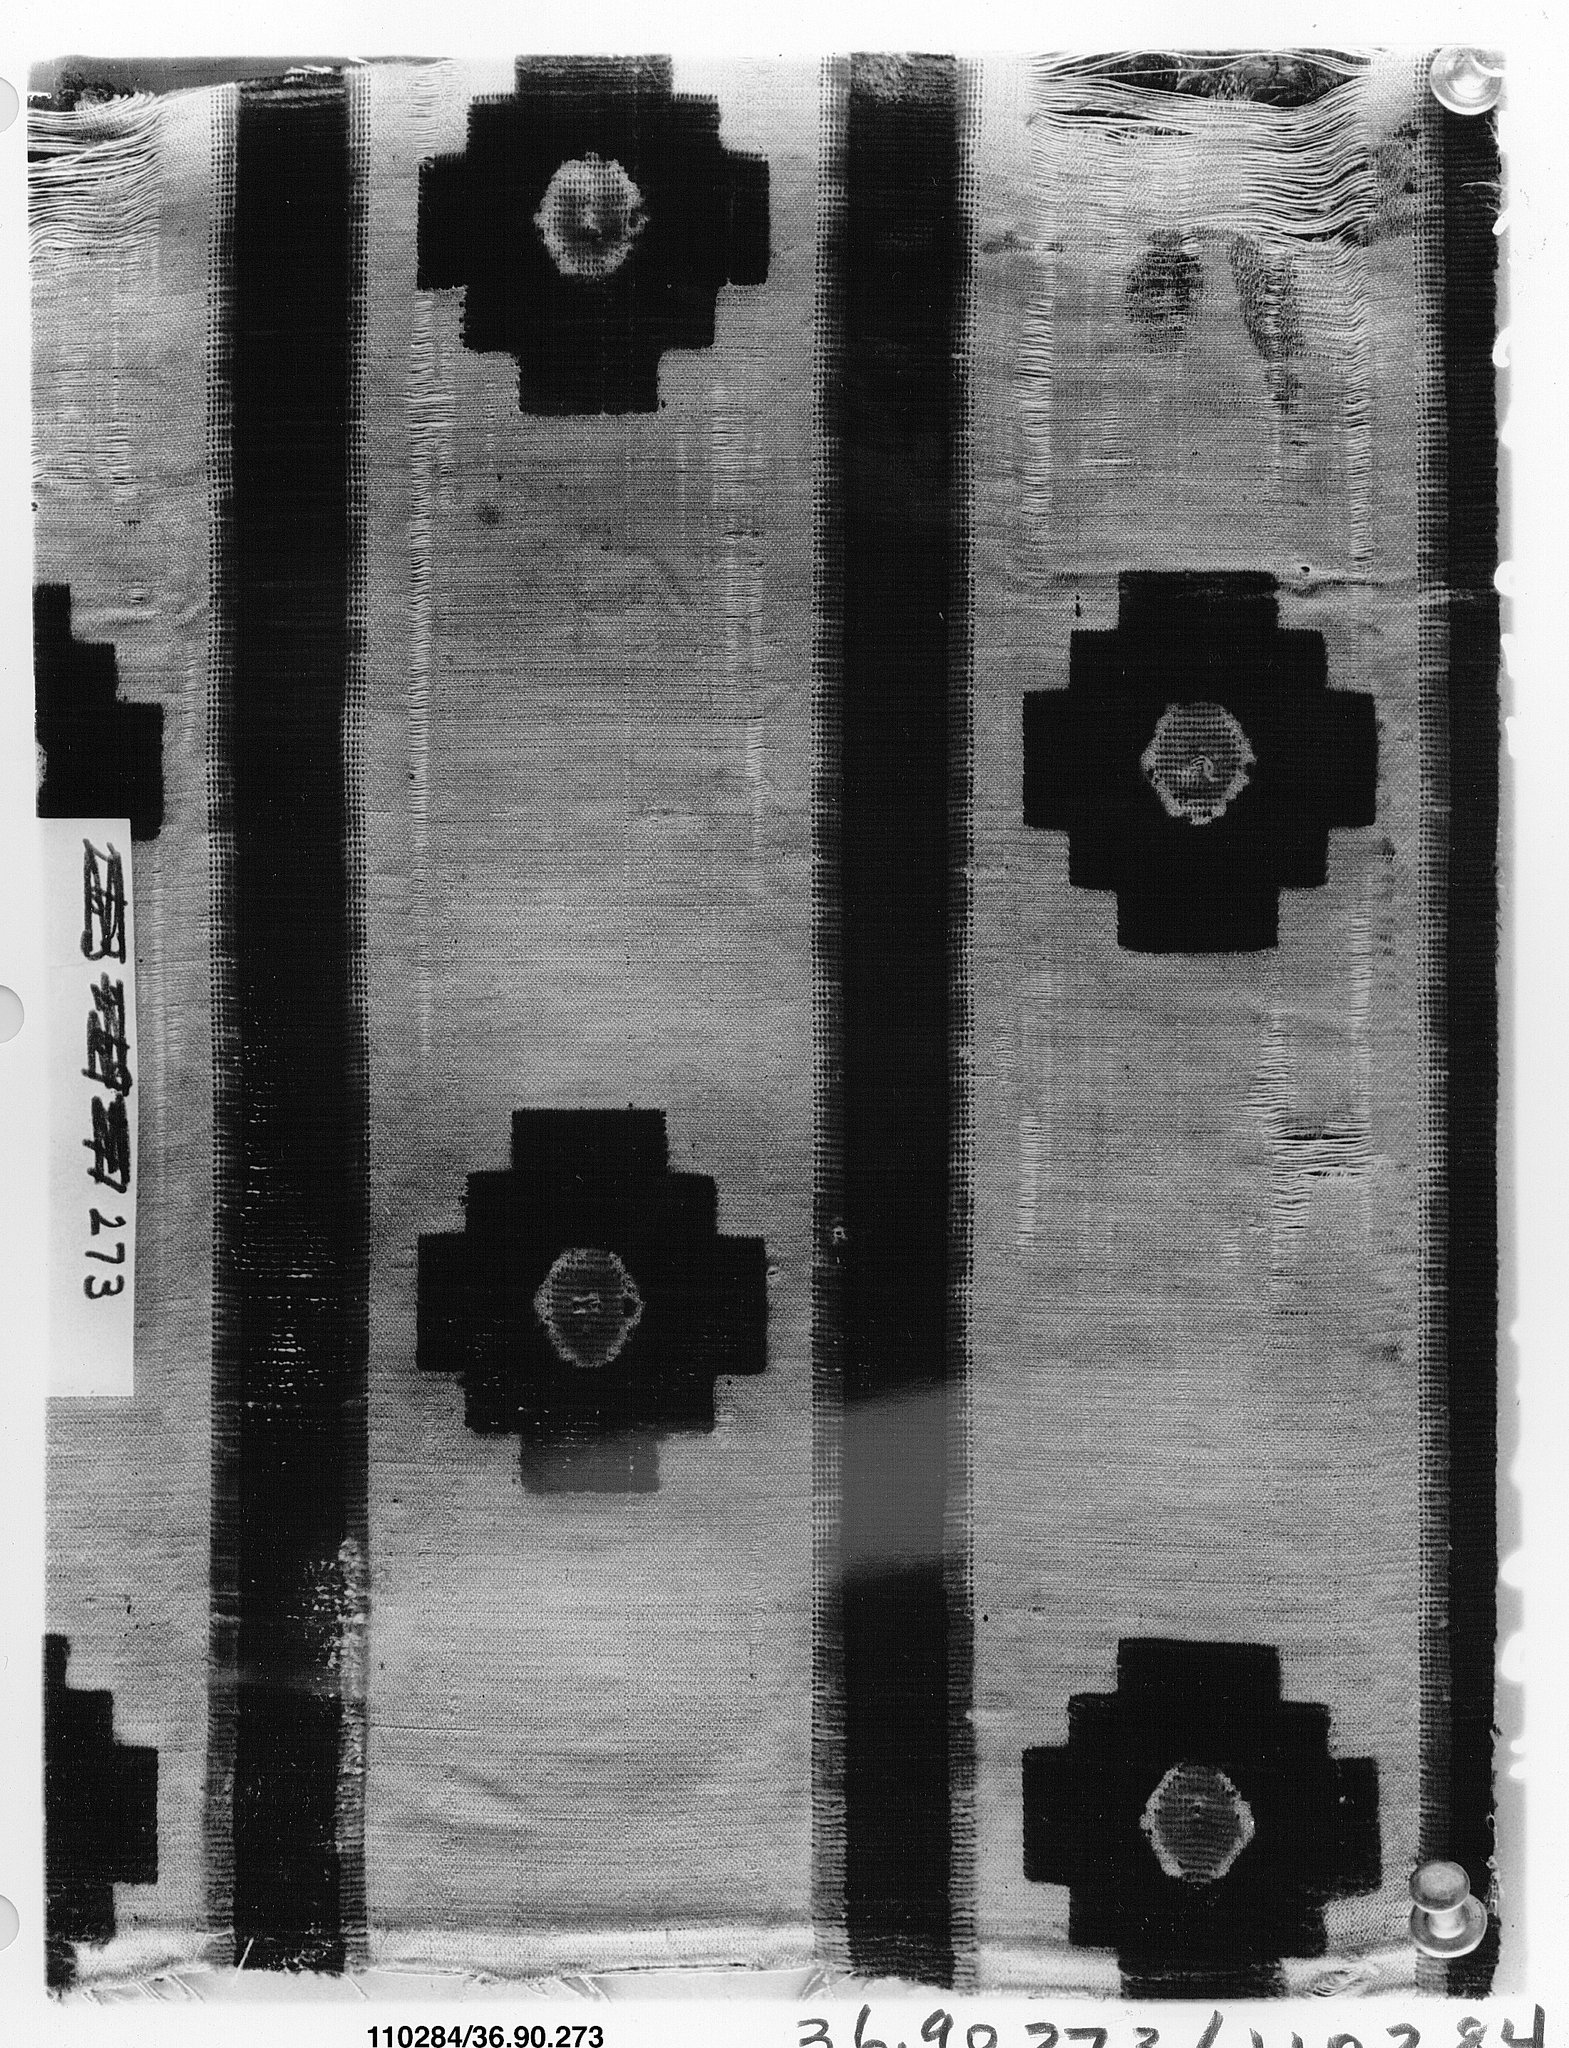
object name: piece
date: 1701-1800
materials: silk